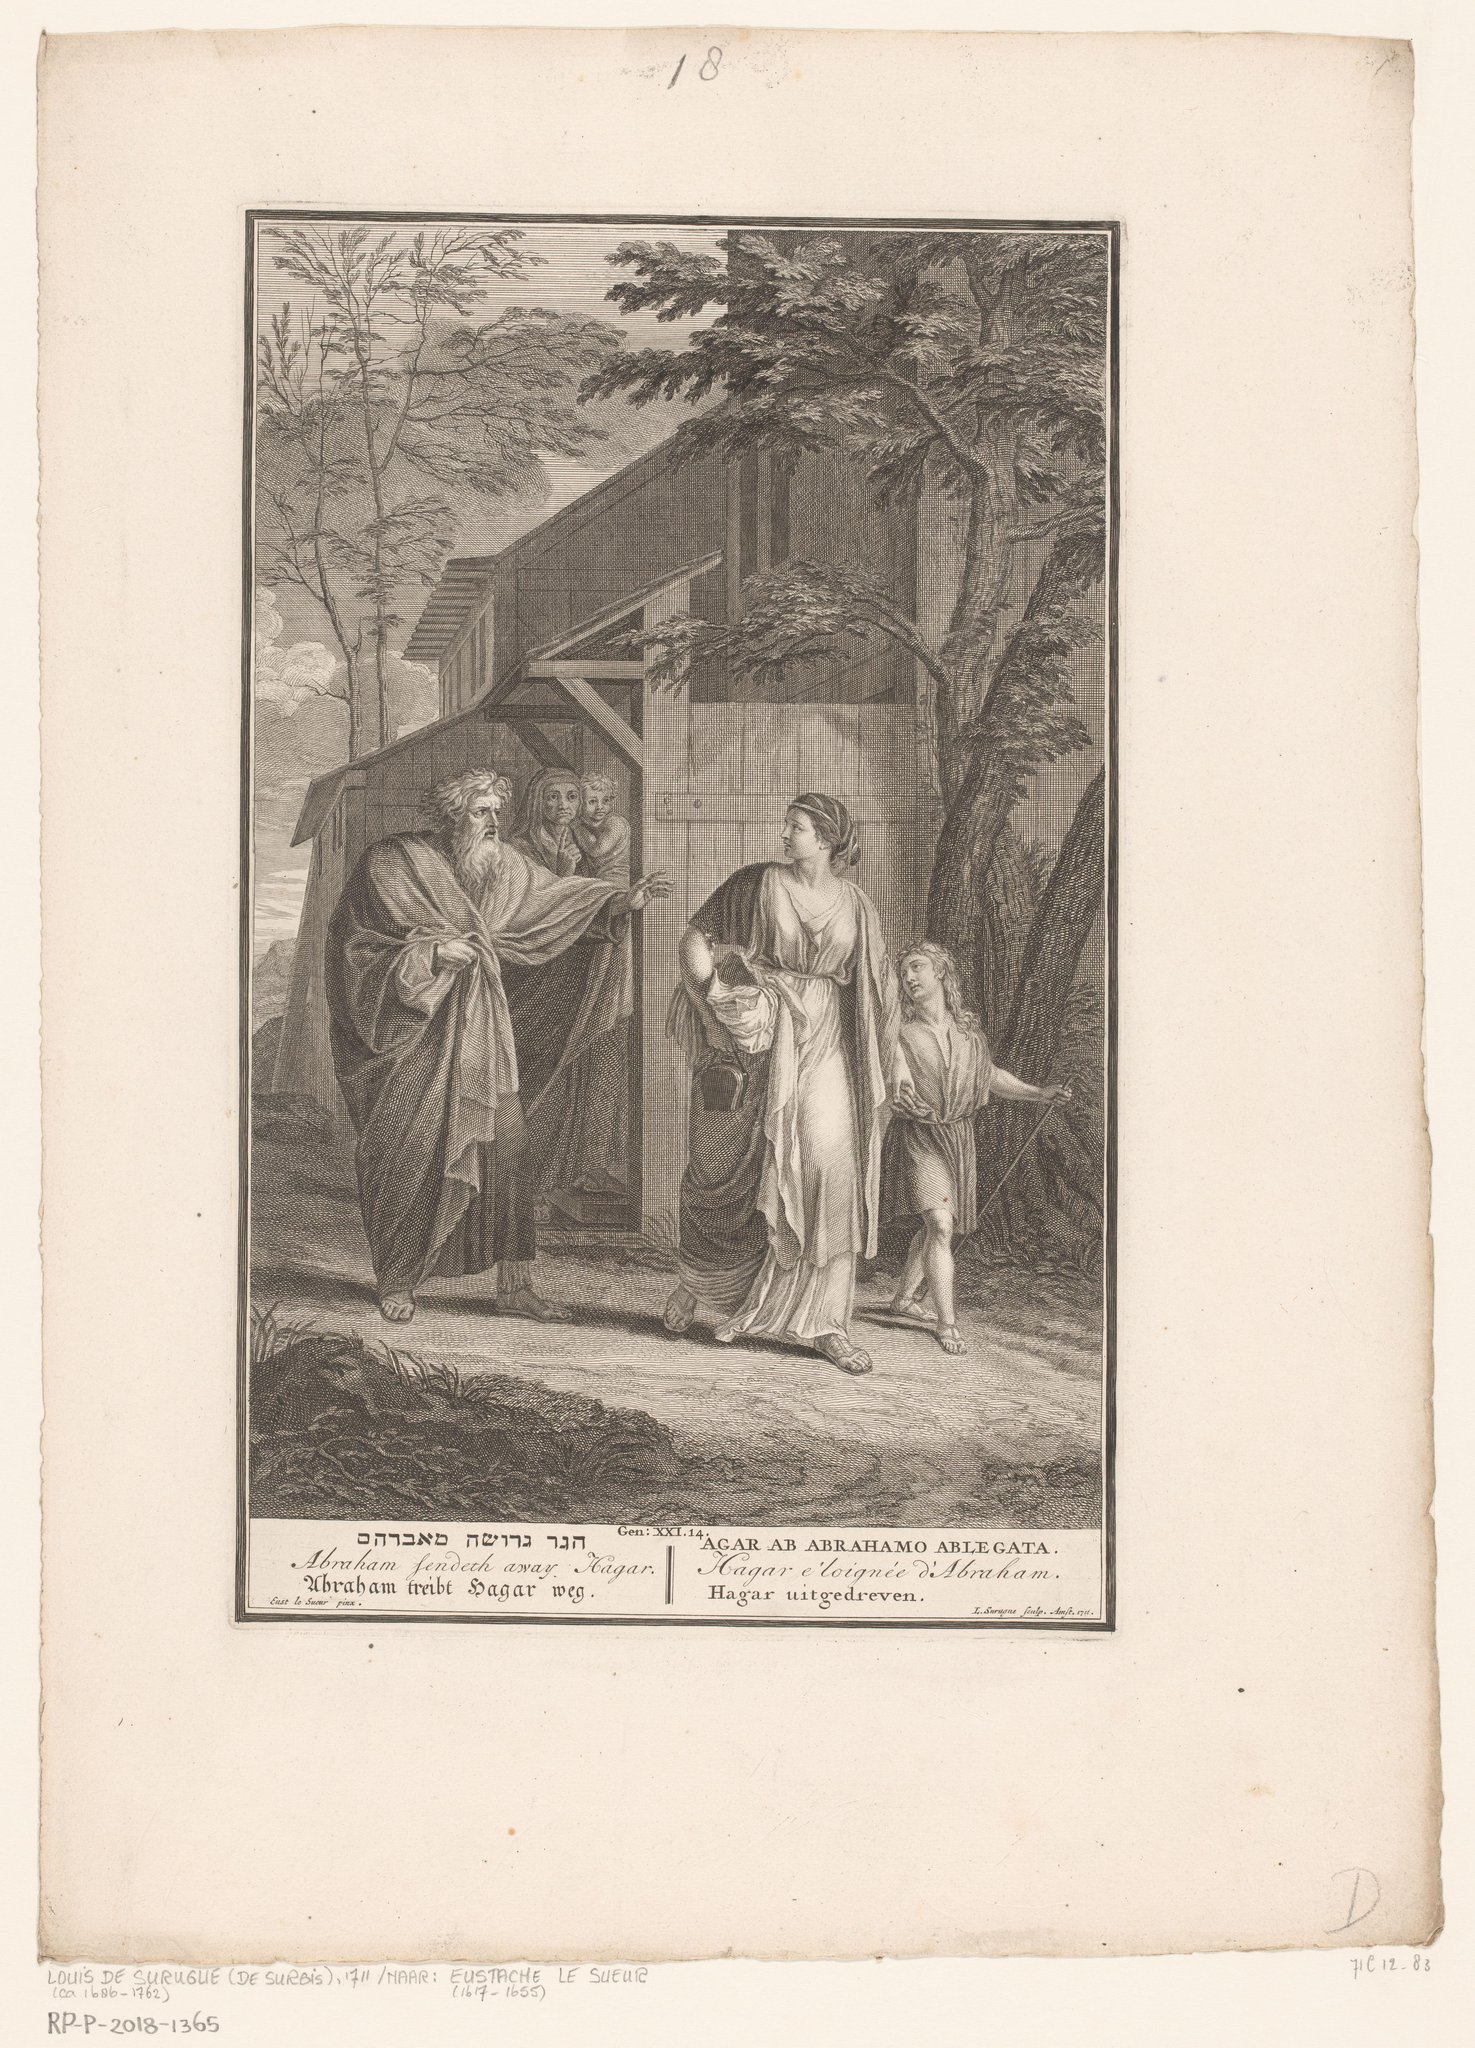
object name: print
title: Abraham verdrijft Hagar en Ismaël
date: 1711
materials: paper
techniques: engraving, etching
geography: amsterdam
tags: hagar and ishmael (often with bow and arrow) depart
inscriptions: collector's mark: Lugt 2228